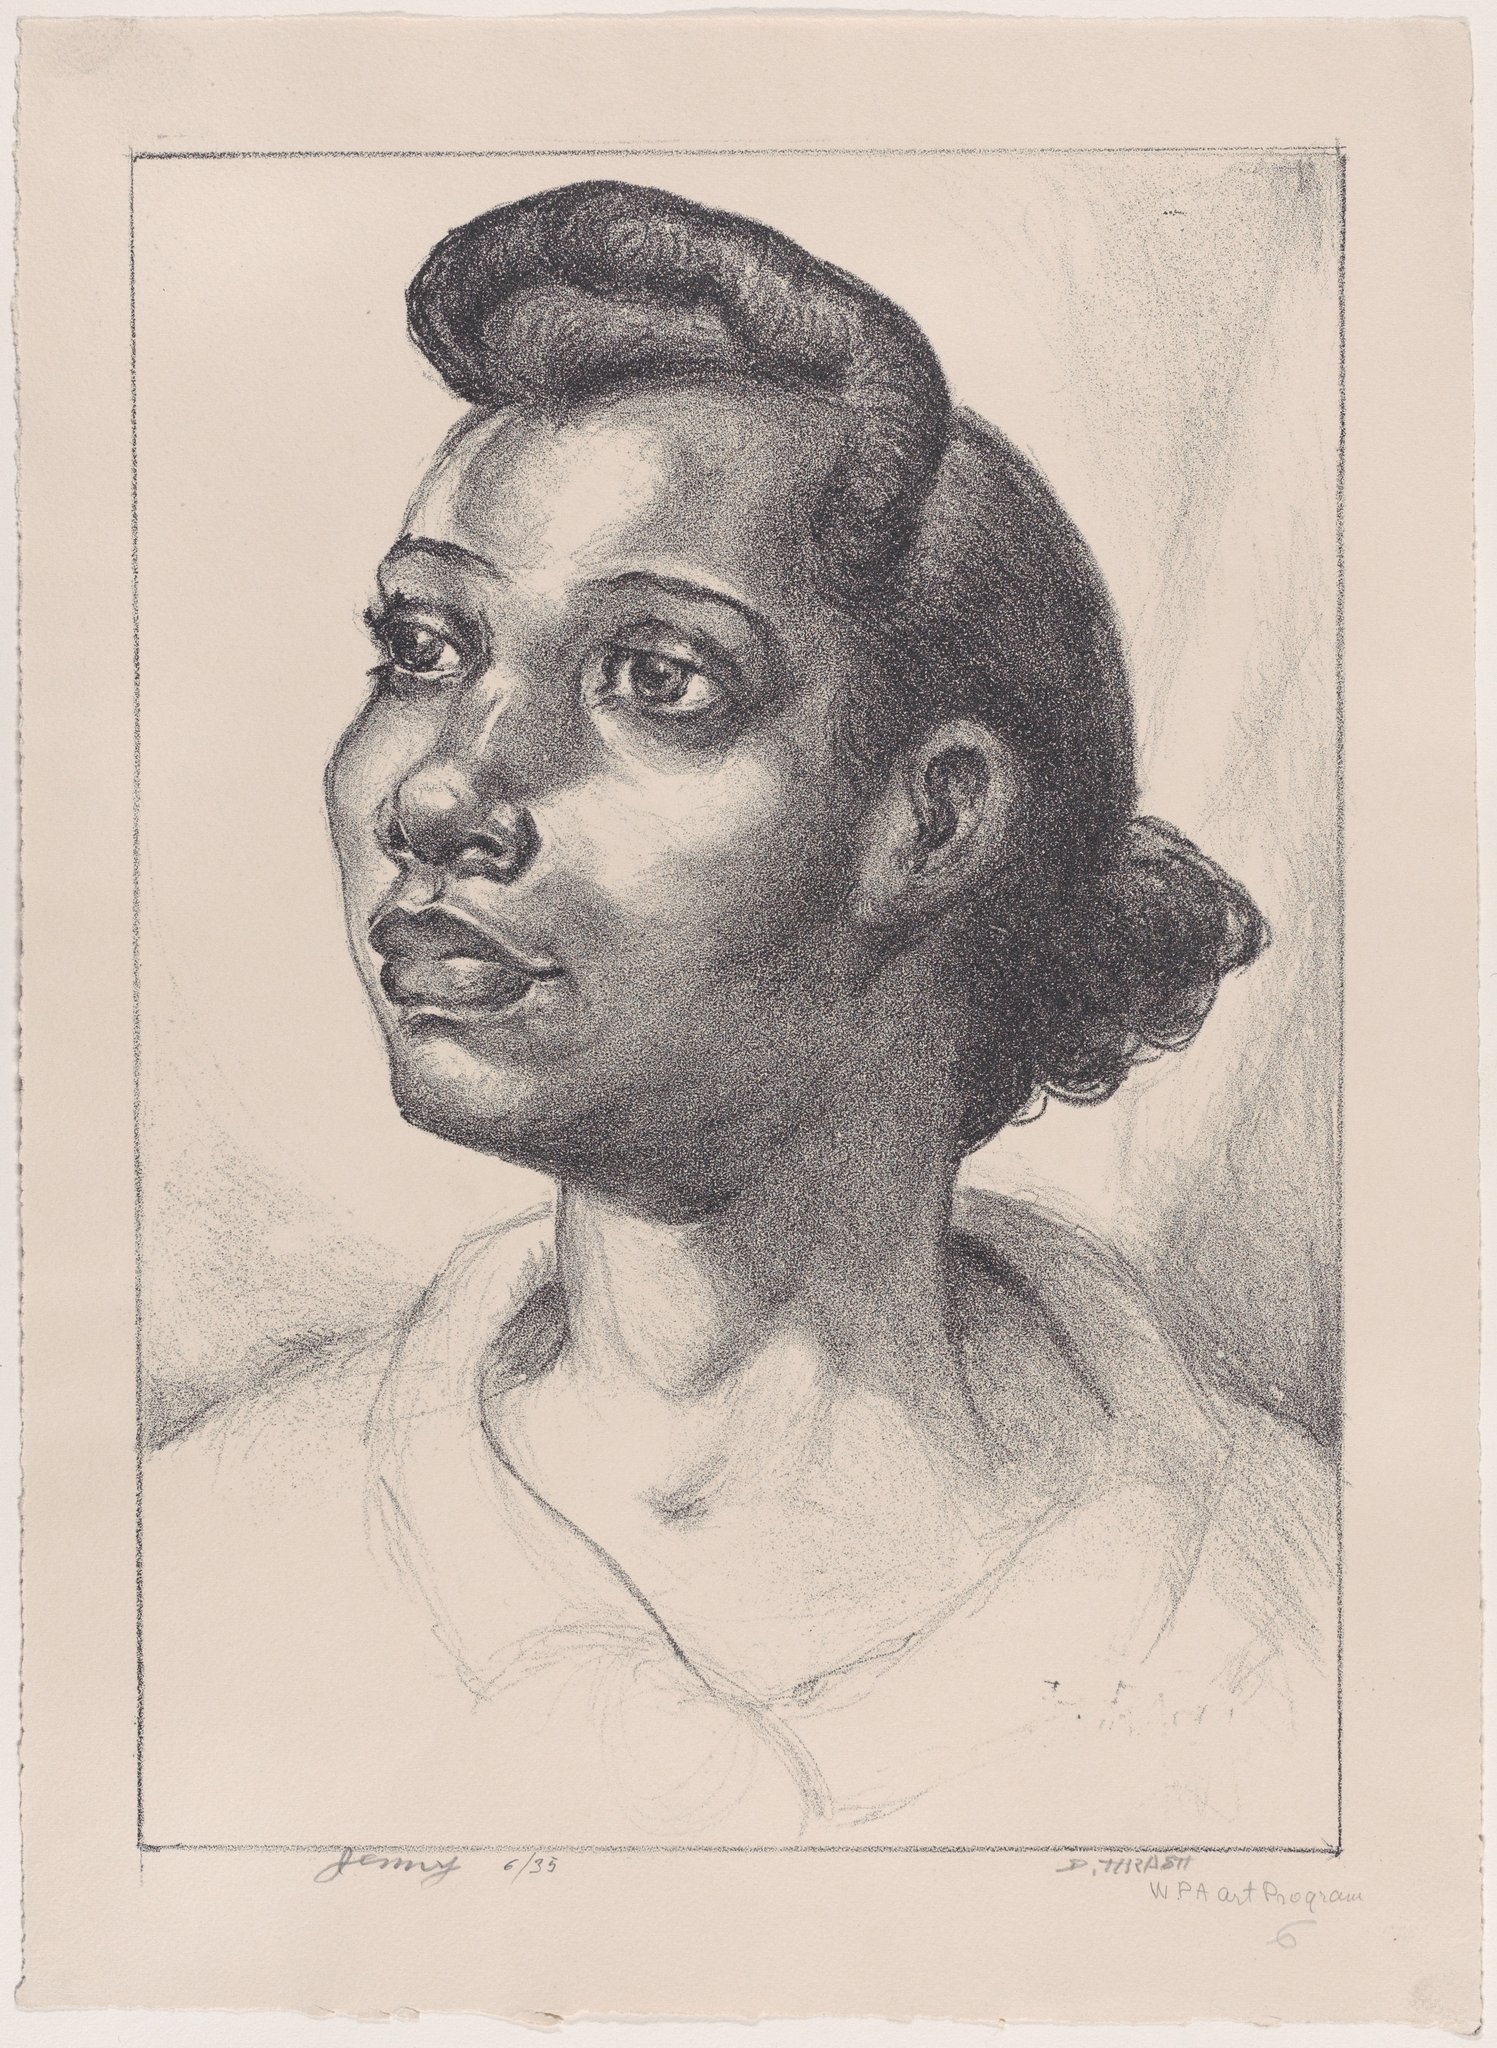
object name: print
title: Jenny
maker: dox thrash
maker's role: artist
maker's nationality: american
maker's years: 1893-1965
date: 1940-1941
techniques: lithograph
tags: portraits,women